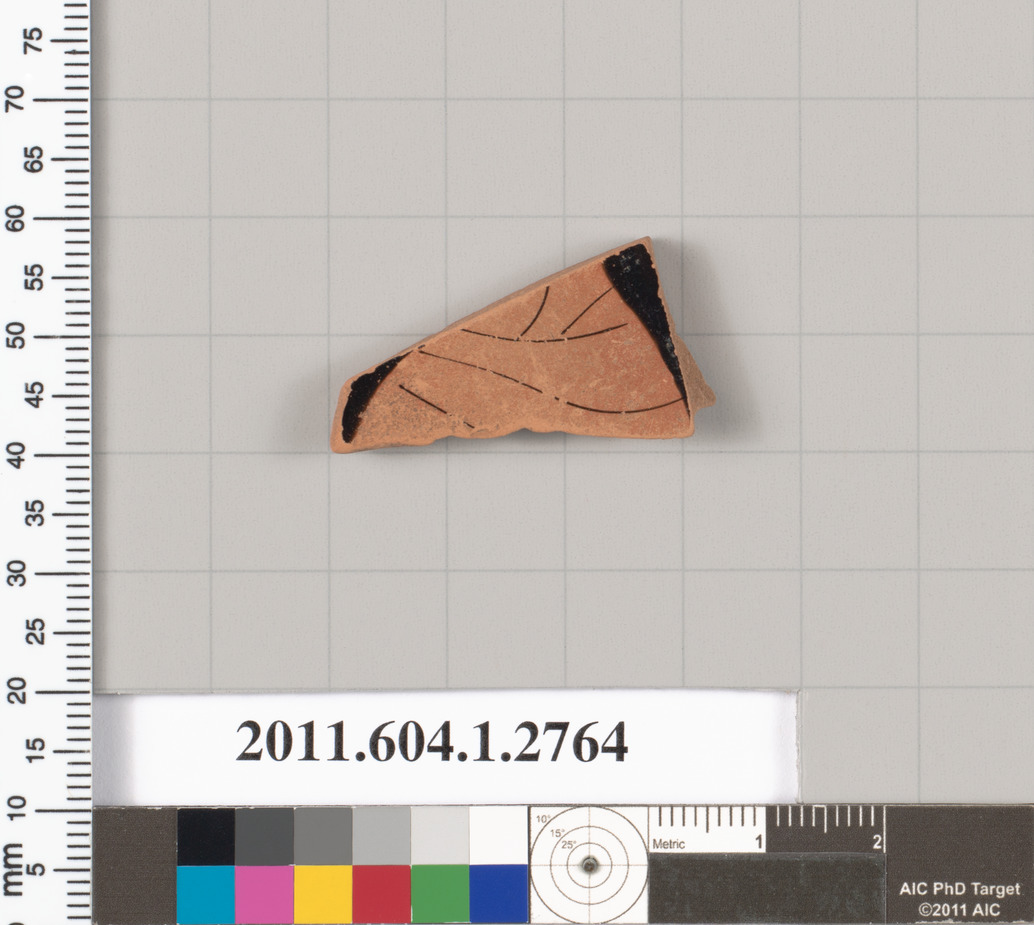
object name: kylix fragment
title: Terracotta fragment of a kylix (drinking cup)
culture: greek, attic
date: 467-435 BCE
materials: terracotta